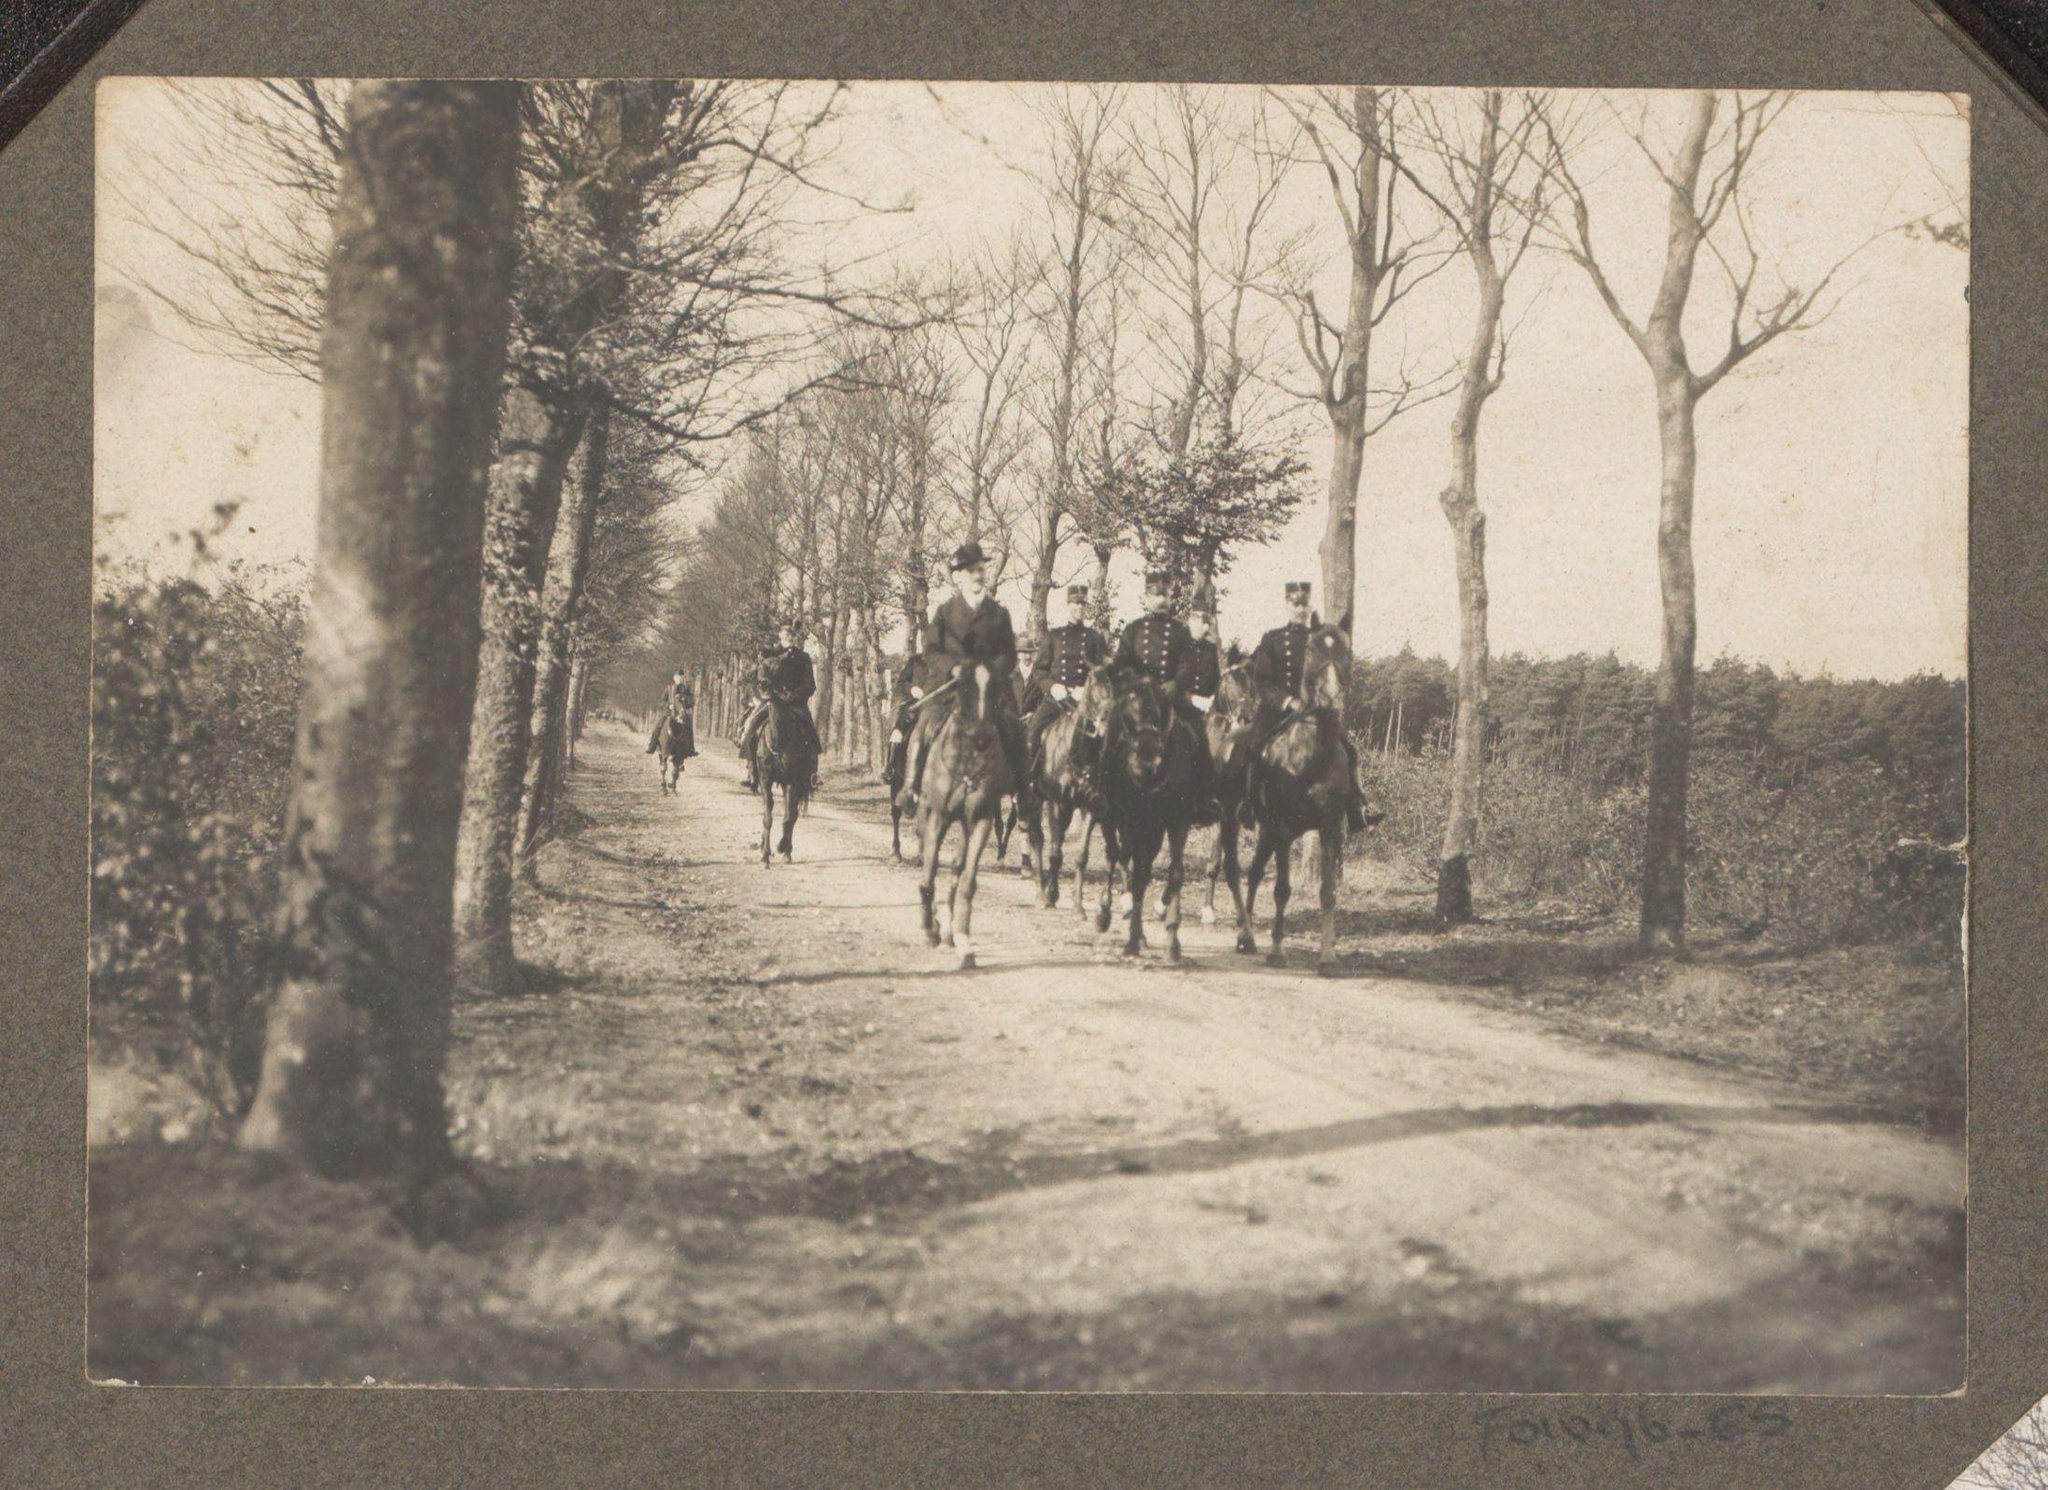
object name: photograph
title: Ruitertafereel op Koninklijke Houtvesterij Het Loo: ruiters op een landweg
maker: Anonymous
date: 1900-1925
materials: photographic support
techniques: gelatin silver print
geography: het loo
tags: riding a horse, ass, or mule; rider, horseman, hunting, chase, hunting-ground, forest path or lane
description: Onderdeel van Fotoalbum van de heer Brams, opperhoutvester van koningin Wilhelmina op Koninklijke Houtvesterij Het Loo.